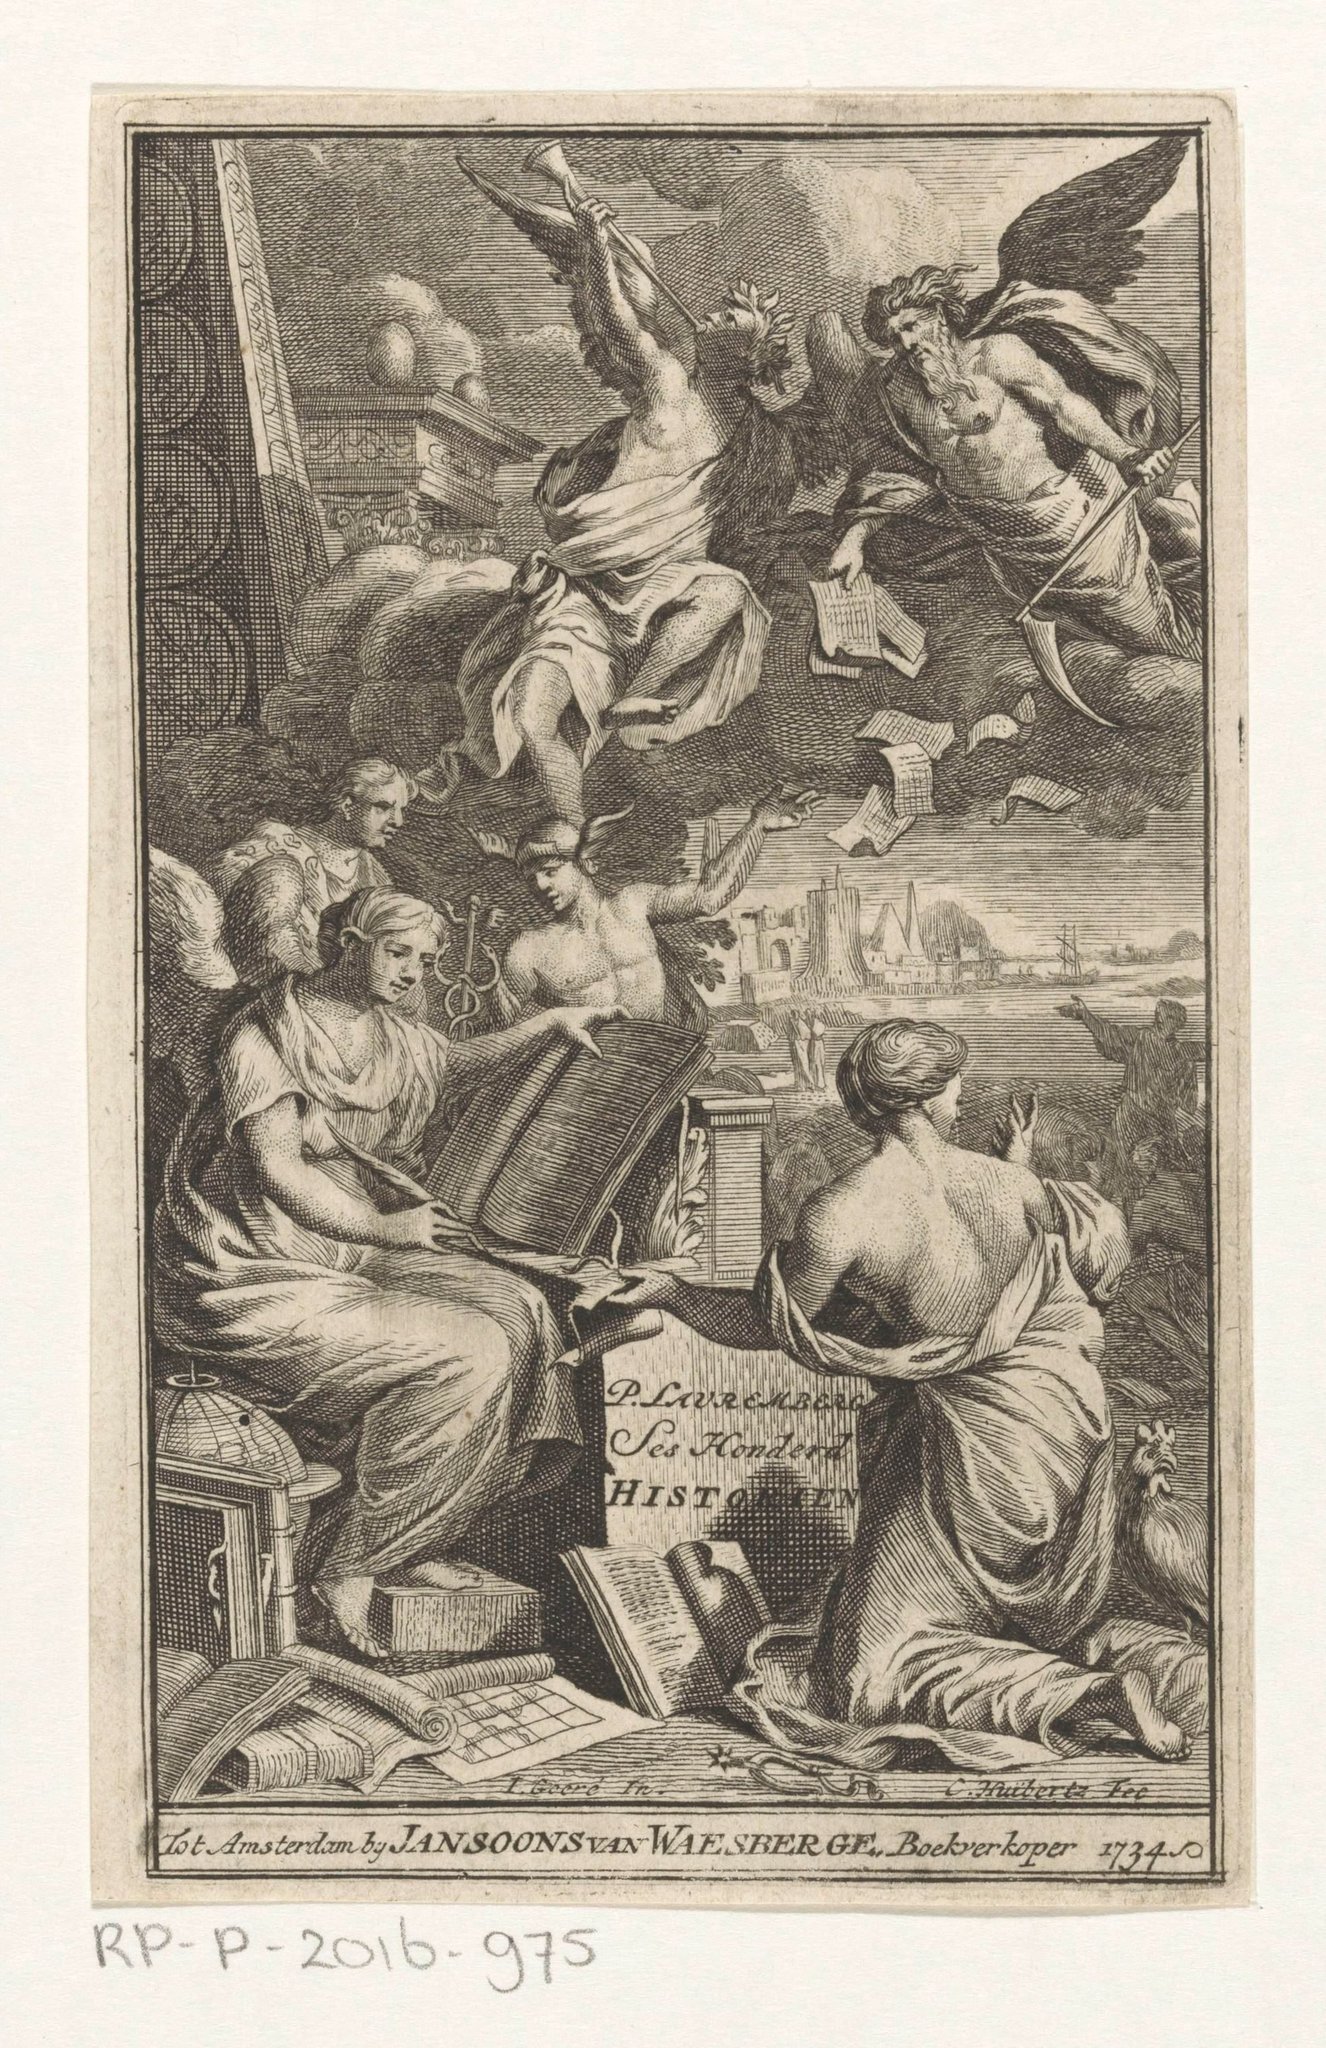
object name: titelblad, titelpagina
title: Allegorische voorstelling met Geschiedenis en Vader Tijd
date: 1734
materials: paper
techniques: engraving, etching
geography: amsterdam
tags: (story of) mercury (hermes), 'historia'; 'historia' (ripa), father time, man with wings and scythe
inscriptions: collector's mark: Lugt 2228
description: Titelpagina voor: Laurenberg, Peter. Het hernieuwde en verbeterde Acerra Philologica, Dat is: zes honder Nutte en Gedenkwaardige geschiedenissen. Amsterdam: Janssonius van Waesberge, 1734. Prent afkomstig uit een plakalbum met titelprenten, ornamenten etc. op blauw papier in 1983 uit elkaar gehaald. Volgens een notitie op verso zat de prent op p. 186 van dit album.